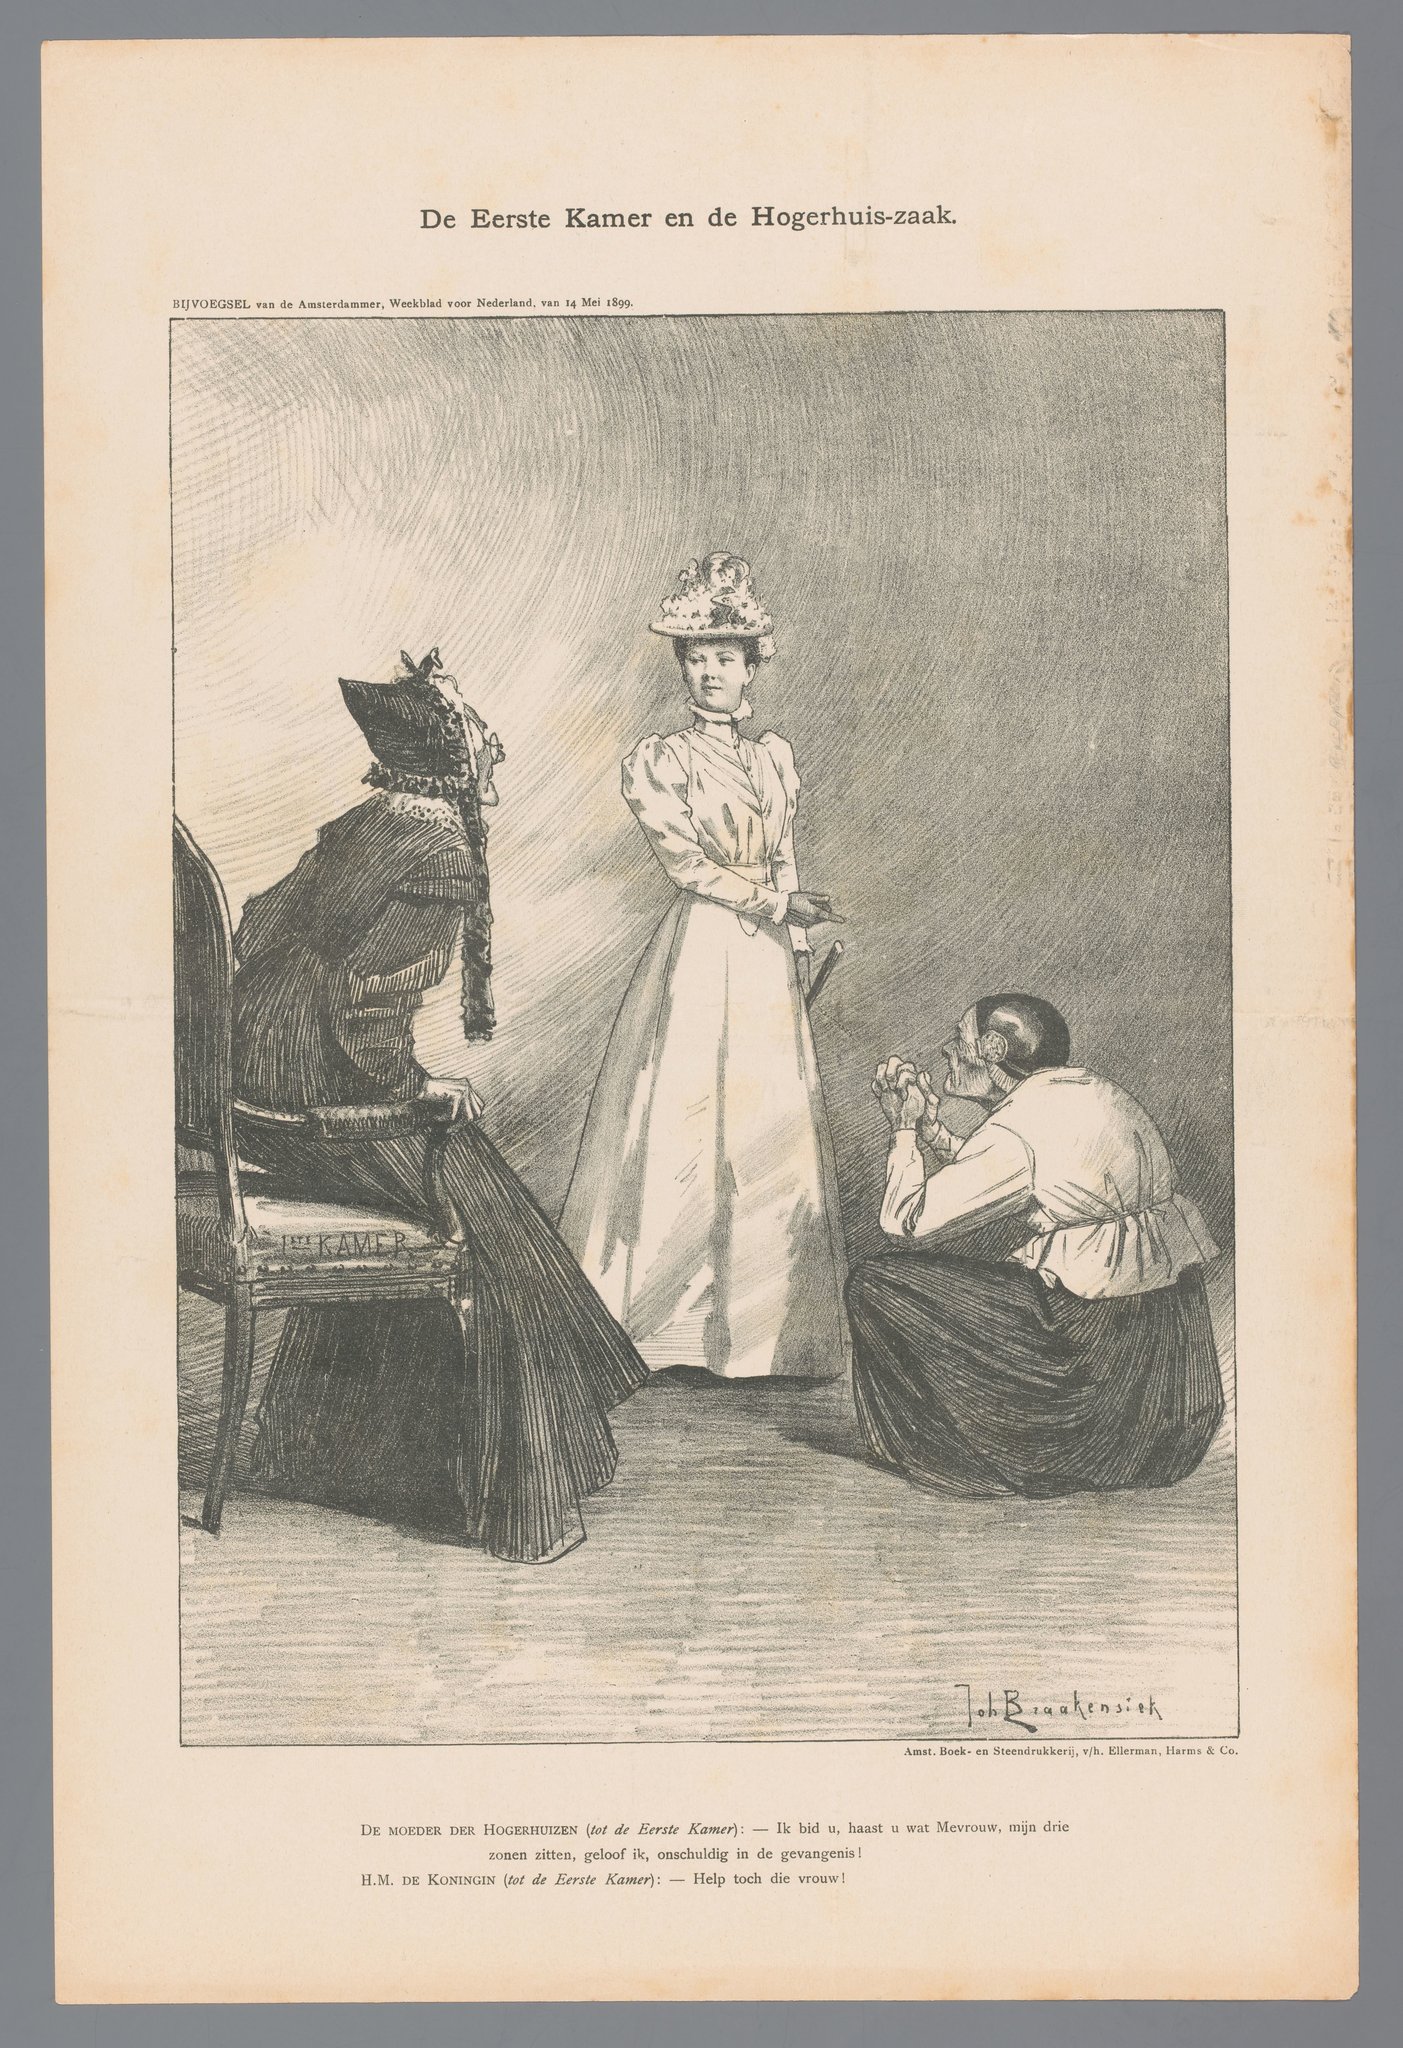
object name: cartoon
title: De Eerste Kamer en de Hogerhuis-zaak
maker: johan braakensiek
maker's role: draughtsman, print maker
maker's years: 1858-1940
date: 1899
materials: paper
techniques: lithograph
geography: amsterdam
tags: the hague, wilhelmina of the netherlands, historical persons, queen, political caricatures and satires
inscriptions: date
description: Prent uit het bijvoegsel van: De Amsterdammer. Weekblad voor Nederland, 14 mei 1899.